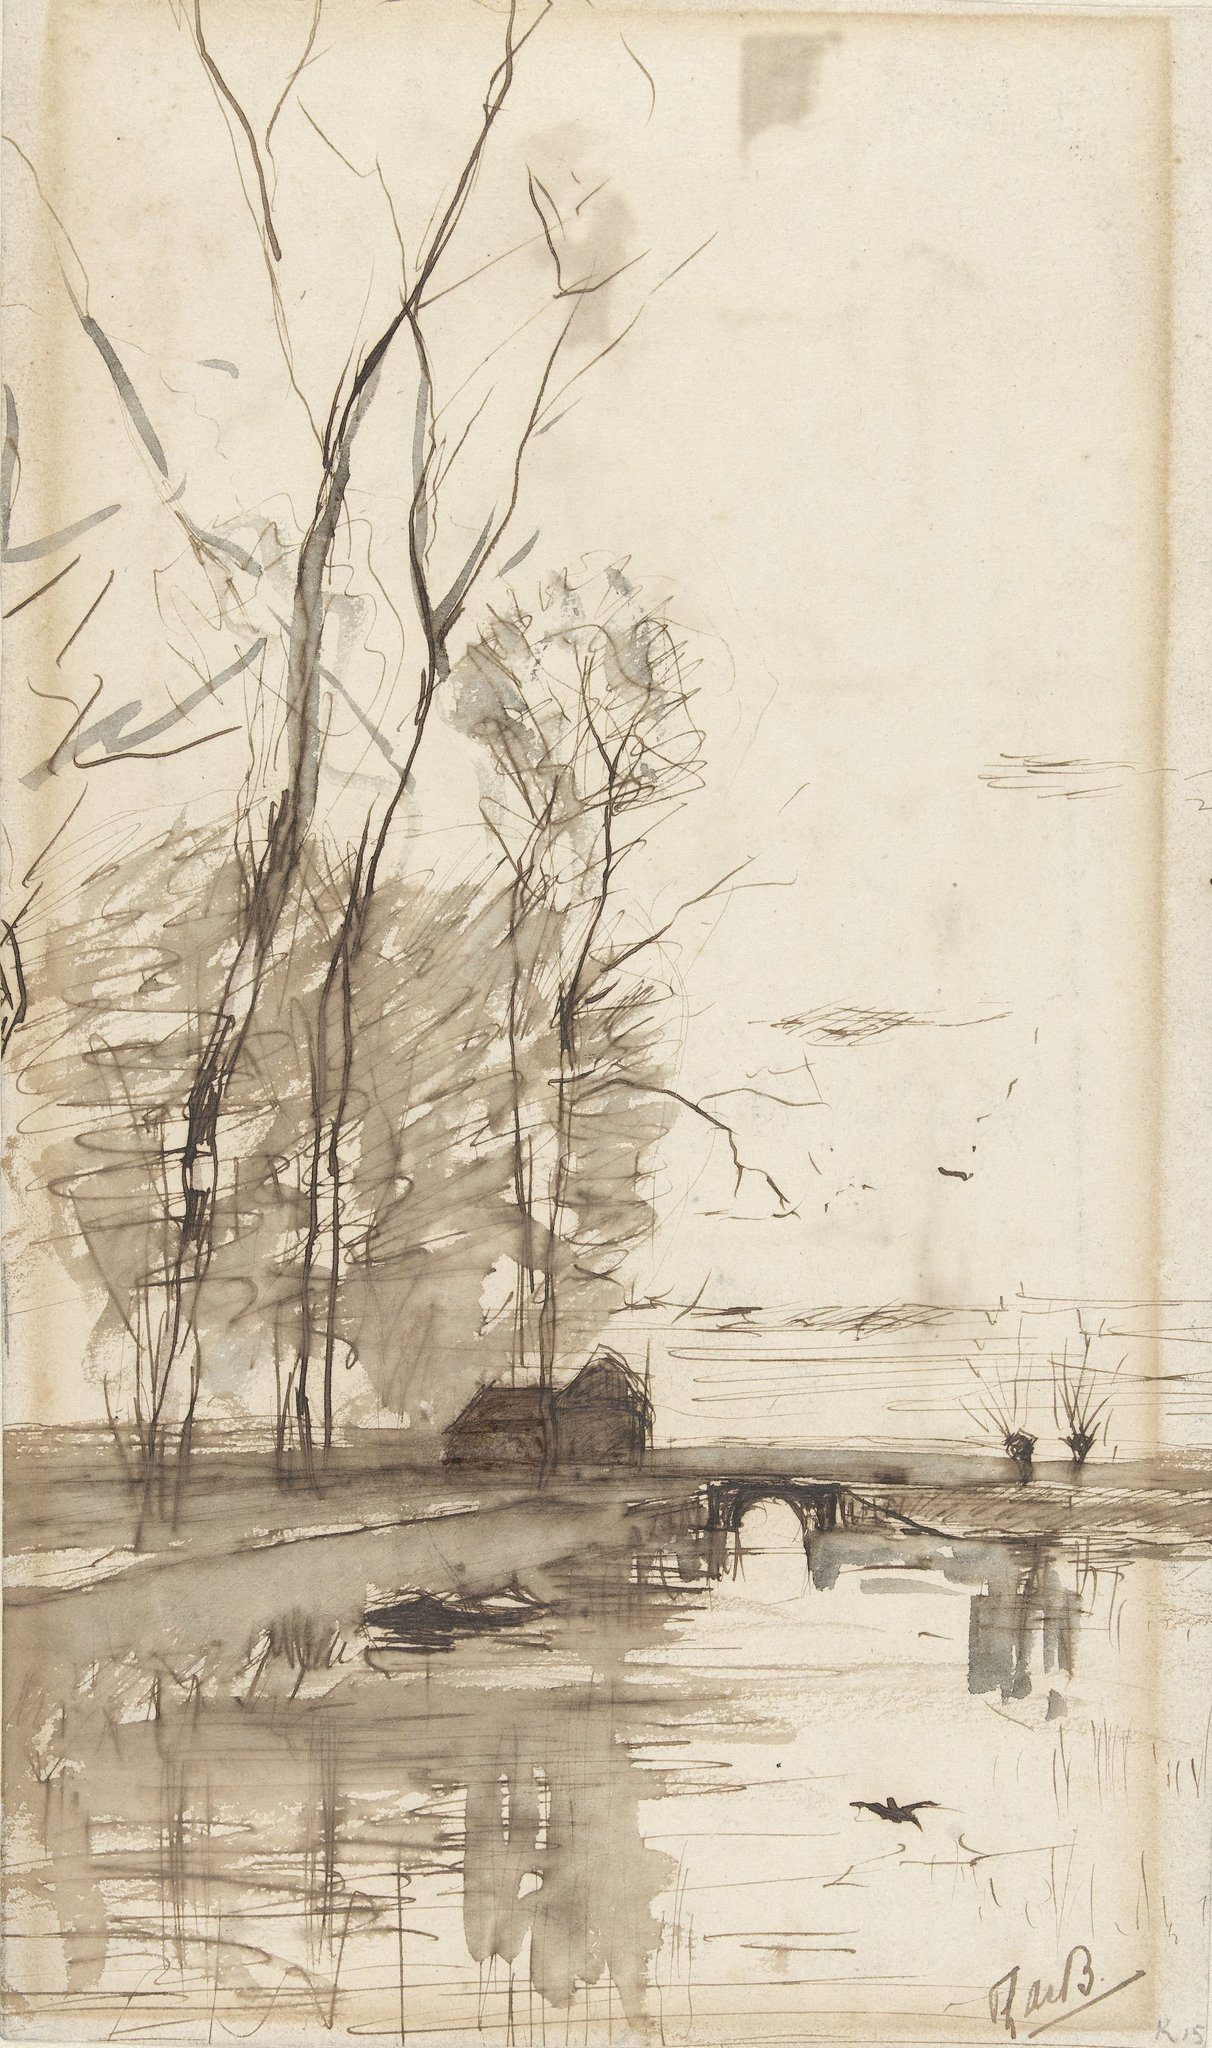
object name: drawing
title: Vaartgezicht met hoge bomen, een boerderijtje en een brug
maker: théophile de bock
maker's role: draughtsman, painter, print maker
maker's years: 1851-1904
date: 1861-1904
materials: ink, paper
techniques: brush, pen